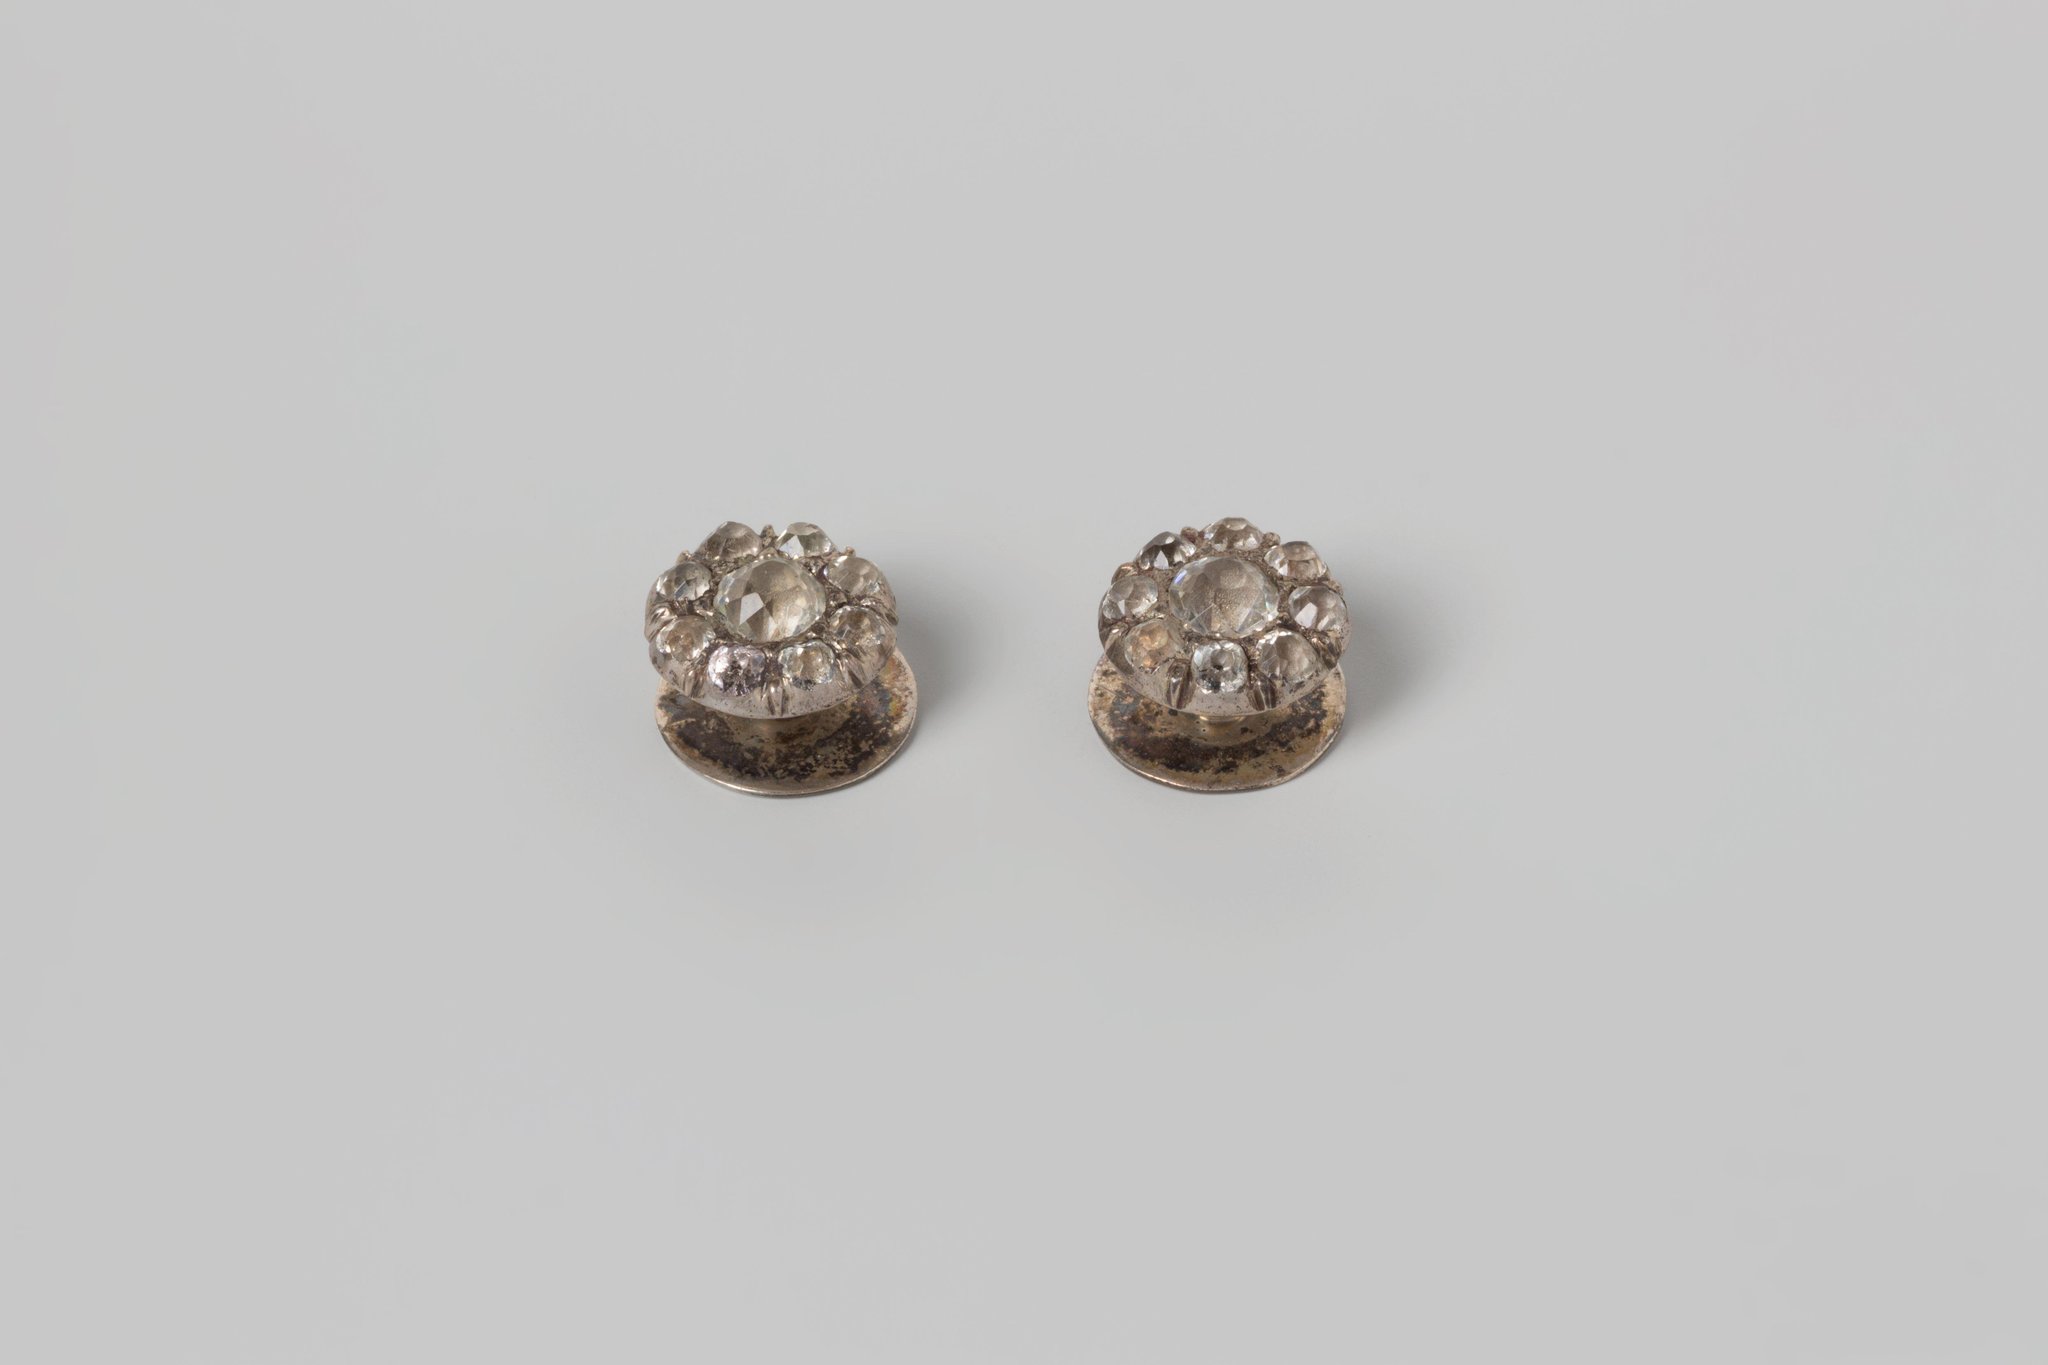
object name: jewellery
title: Hemdsknopen van zilver met rozet van strasz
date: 1700-1799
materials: paste, silver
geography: amsterdam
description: Twee hemdsknopen van zilver versierd met een rozet van strasz. Gemerkt met een boompje in een wapenschild.